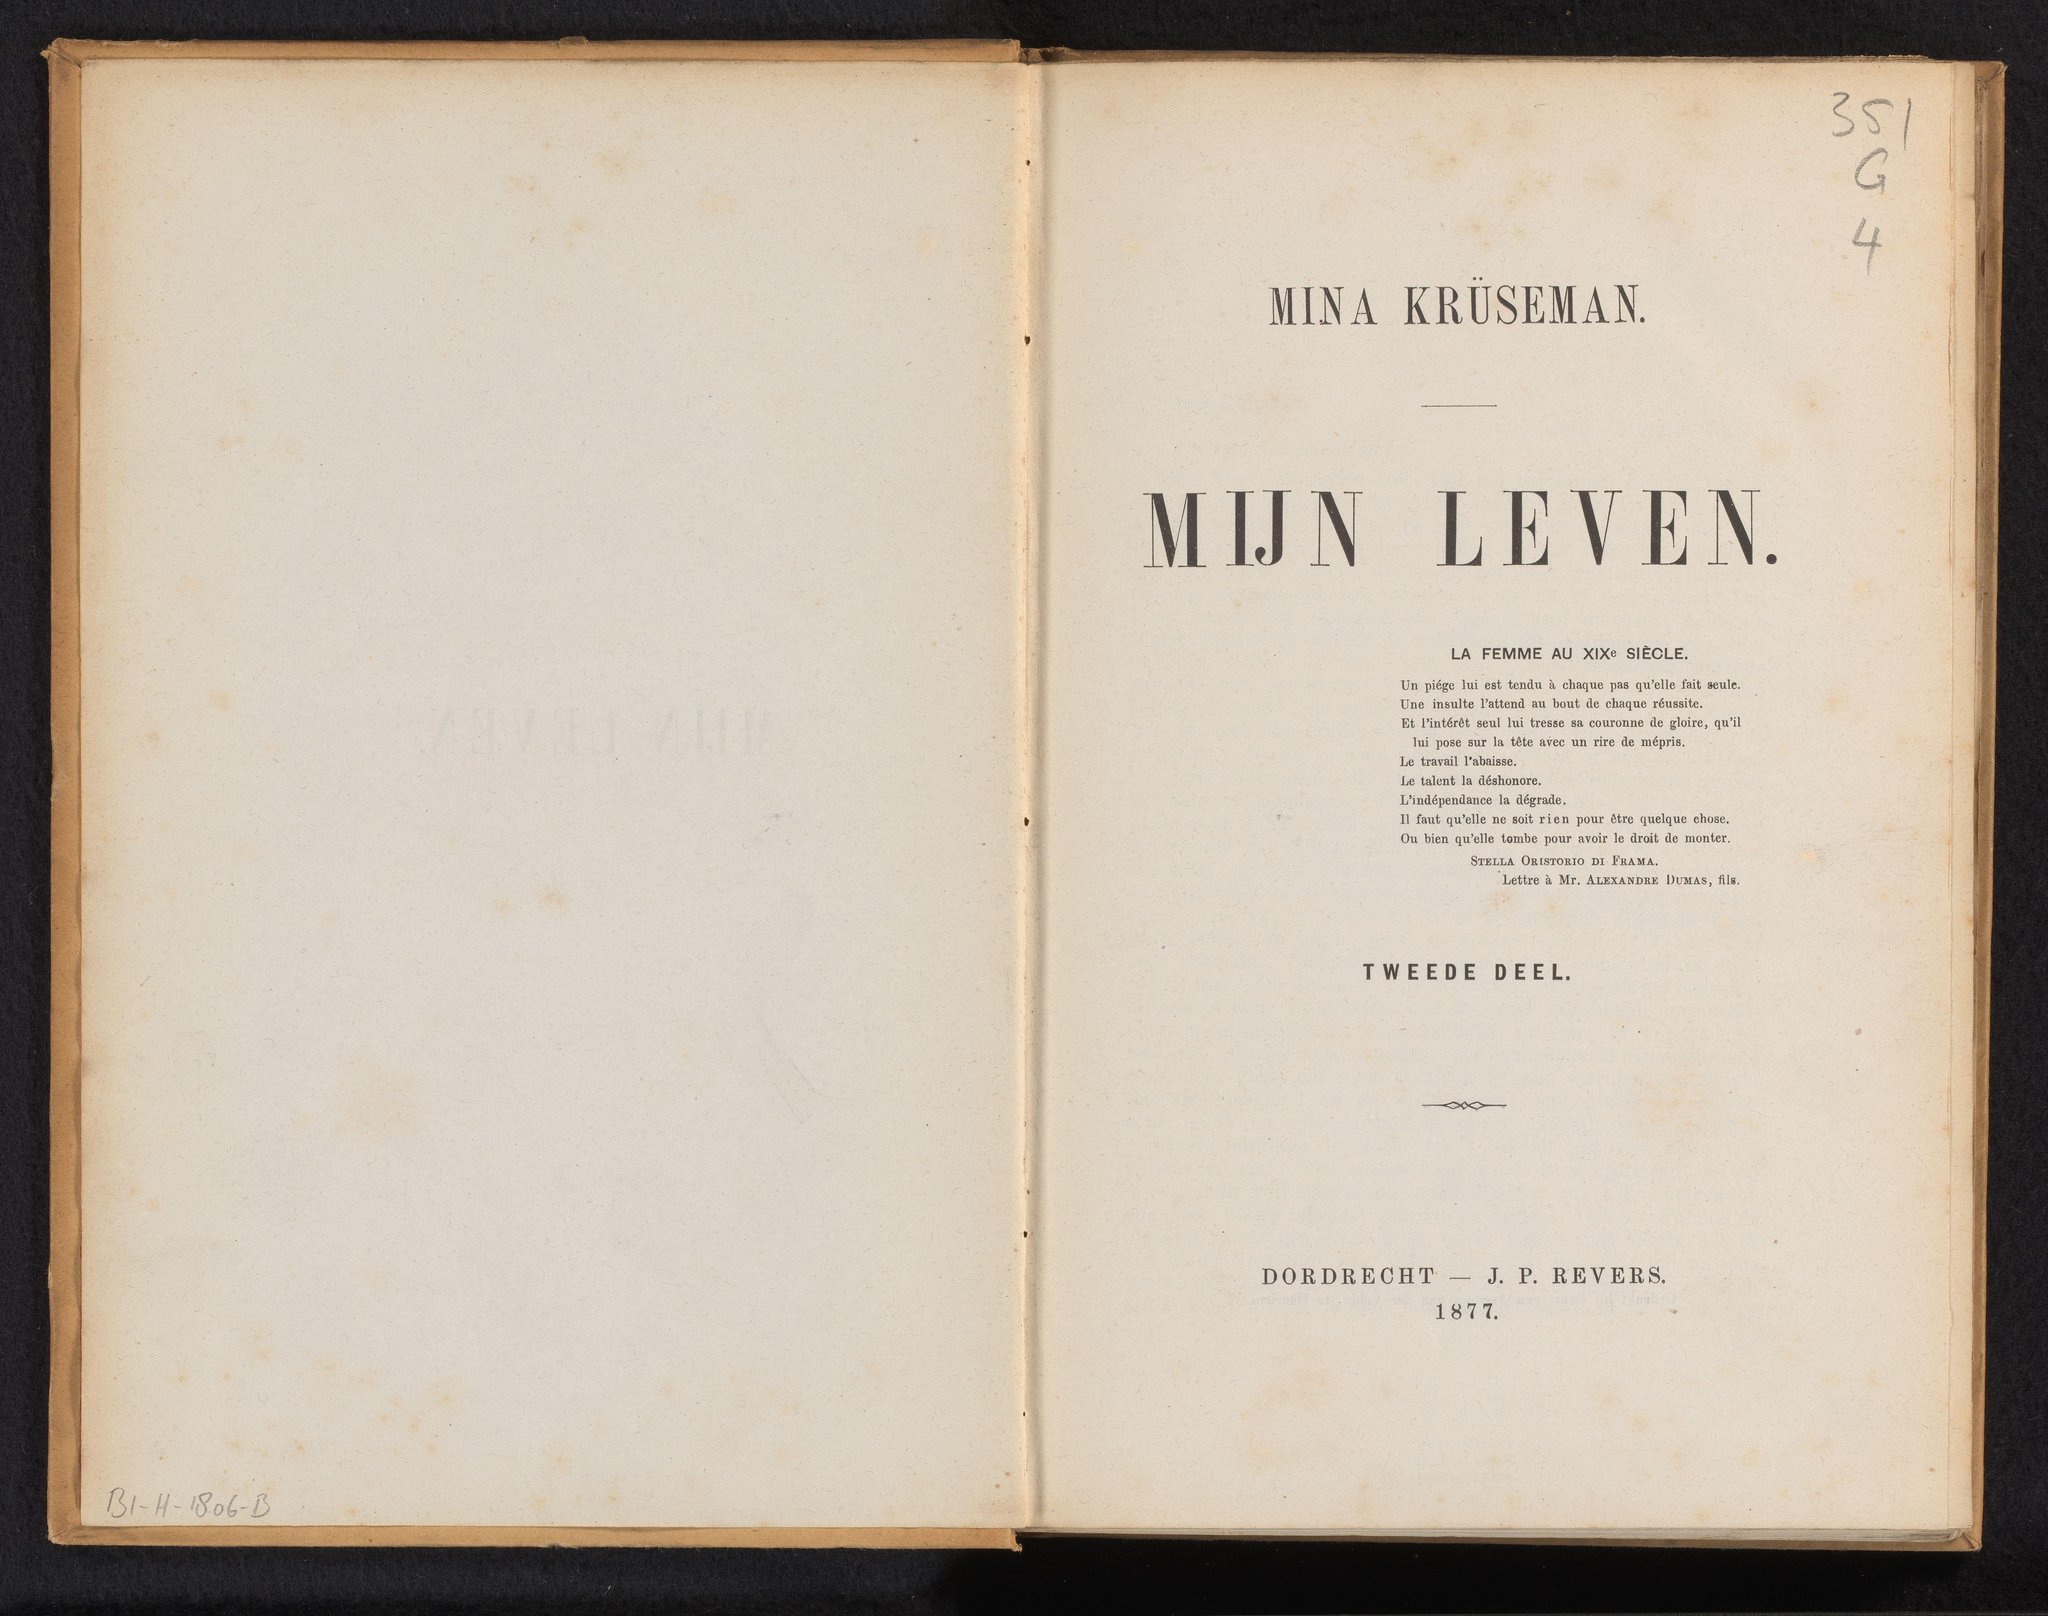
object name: book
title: Mijn leven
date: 1877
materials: cardboard, paper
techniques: printing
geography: dordrecht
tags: mina kruseman